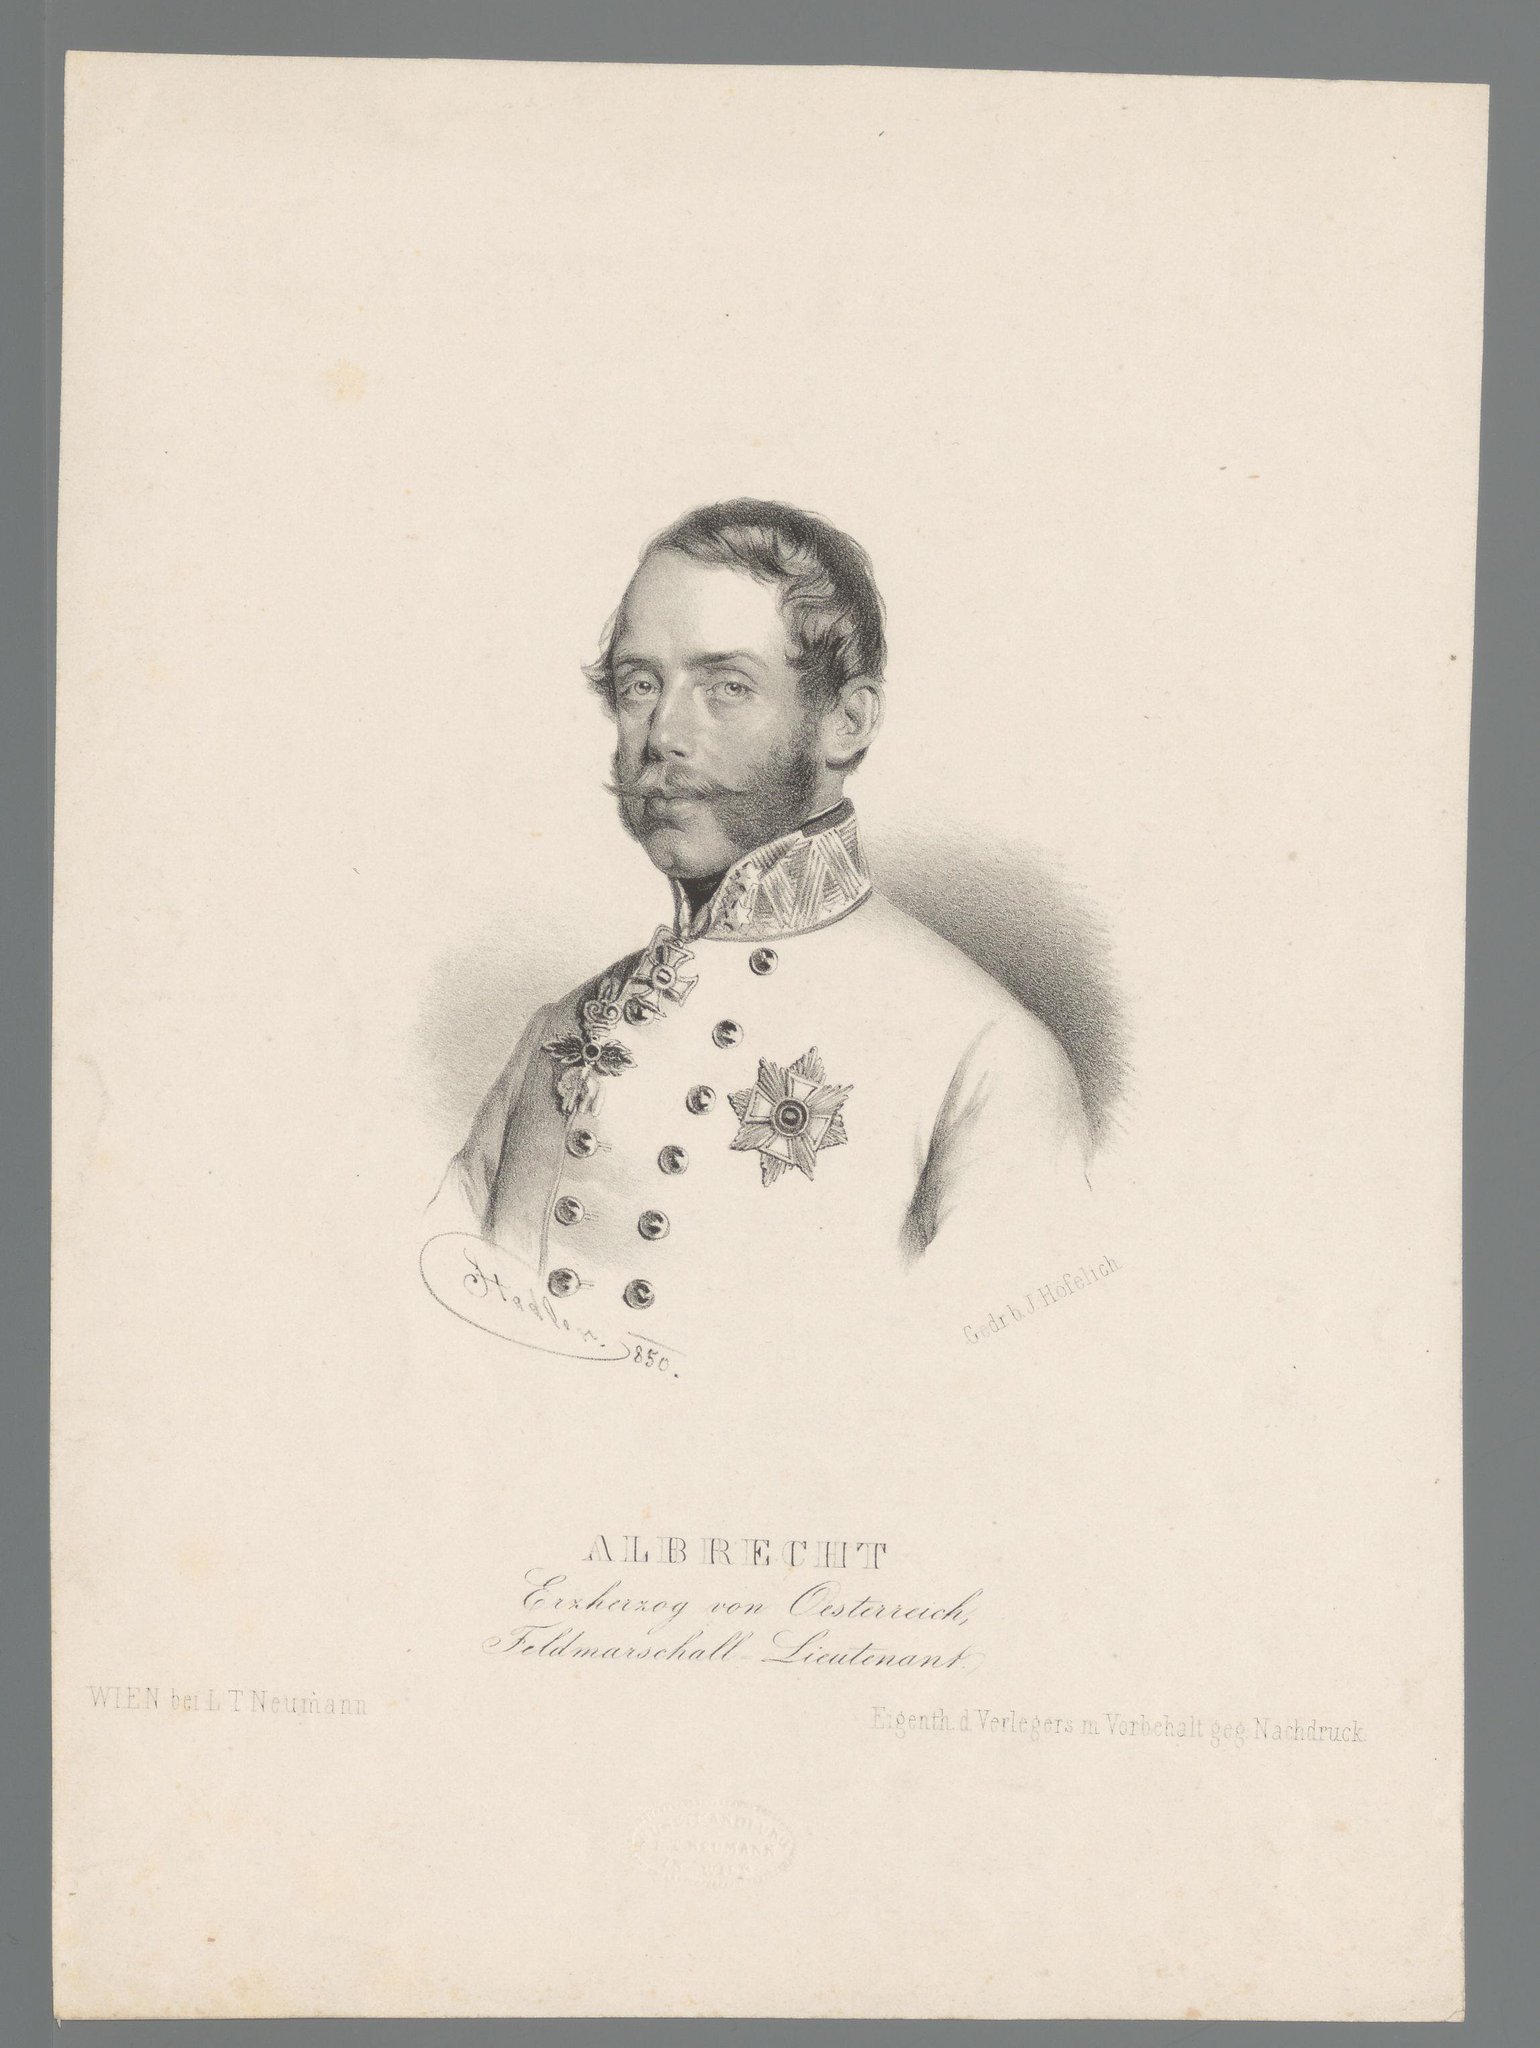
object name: print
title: Portret van Albrecht van Oostenrijk-Teschen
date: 1850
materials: paper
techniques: lithograph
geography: vienna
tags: vienna, moustache, adult man, historical persons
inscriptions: collector's mark: Lugt 2228, check stamp: ‘Kunsthandlung L.T. Neumann in Wien’